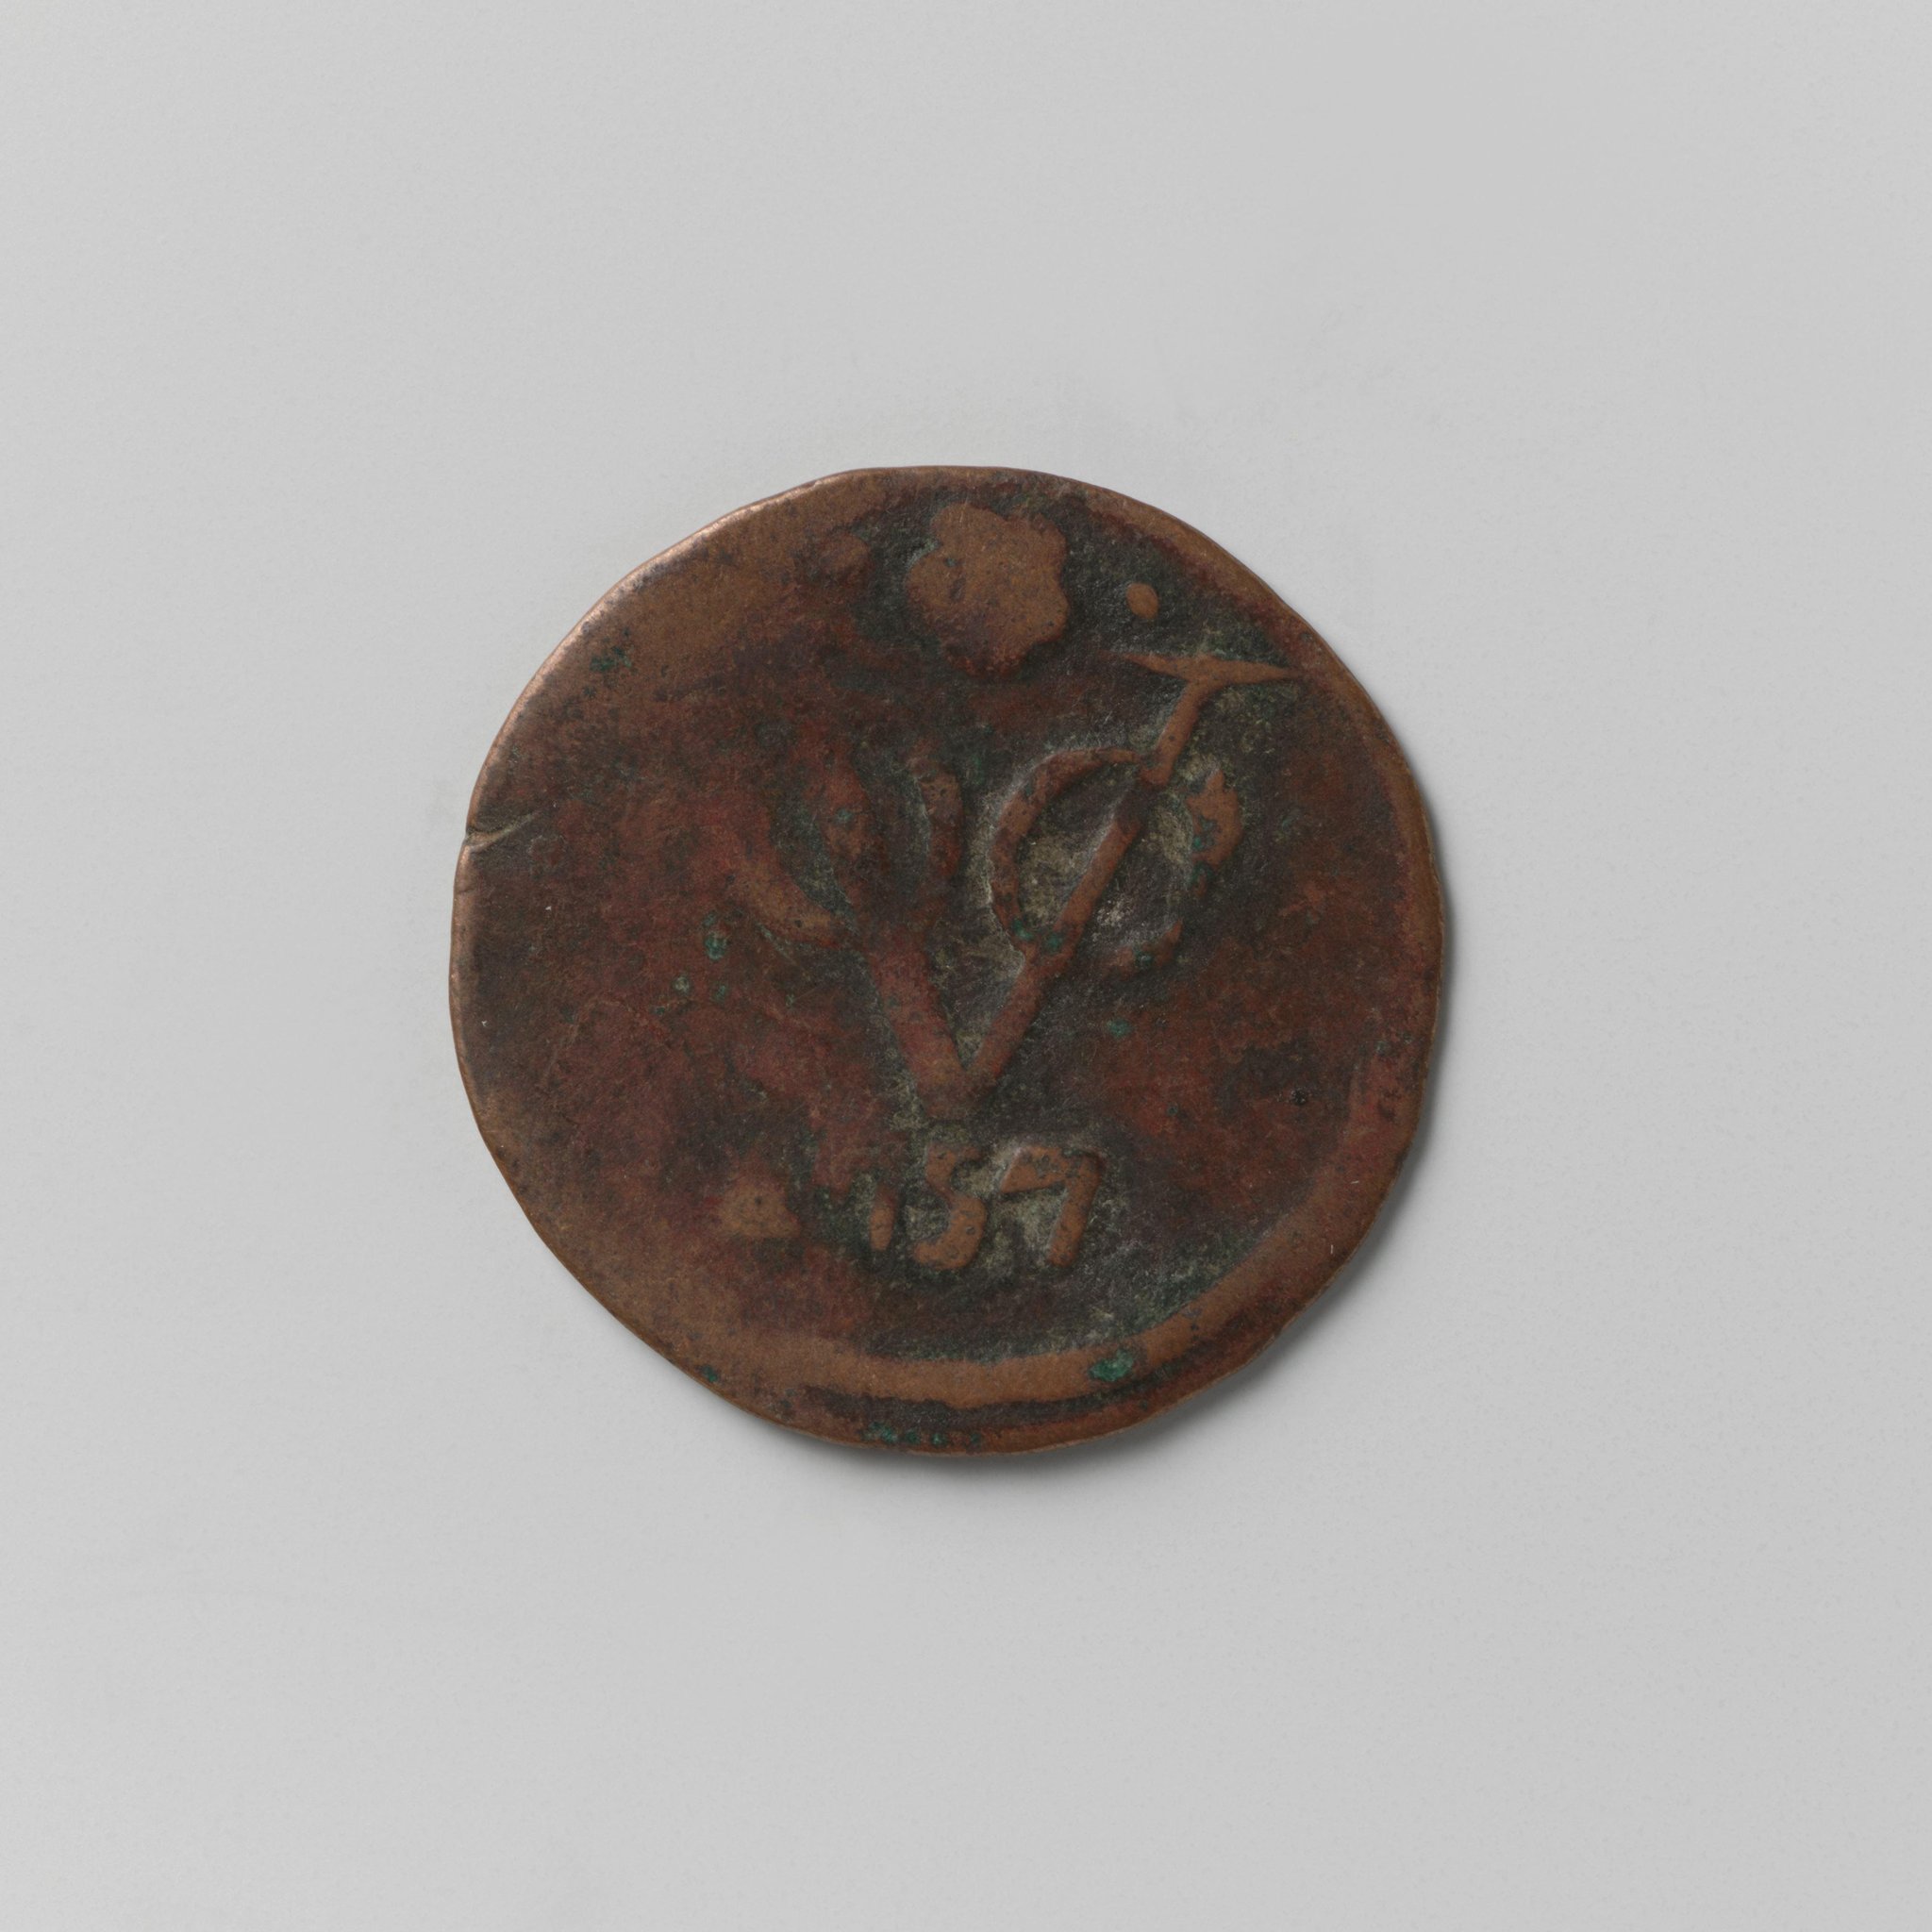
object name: coin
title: Nabootsing van VOC- duit Holland, 1757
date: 1757-1830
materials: copper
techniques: striking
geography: banjarmasin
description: Koperen munt. Nabootsing van duit van de VOC uit Holland. Voorzijde: gekroond wapenschild van Holland. Keerzijde: monogram van de VOC, waarboven punt en waaronder fictief jaartal.